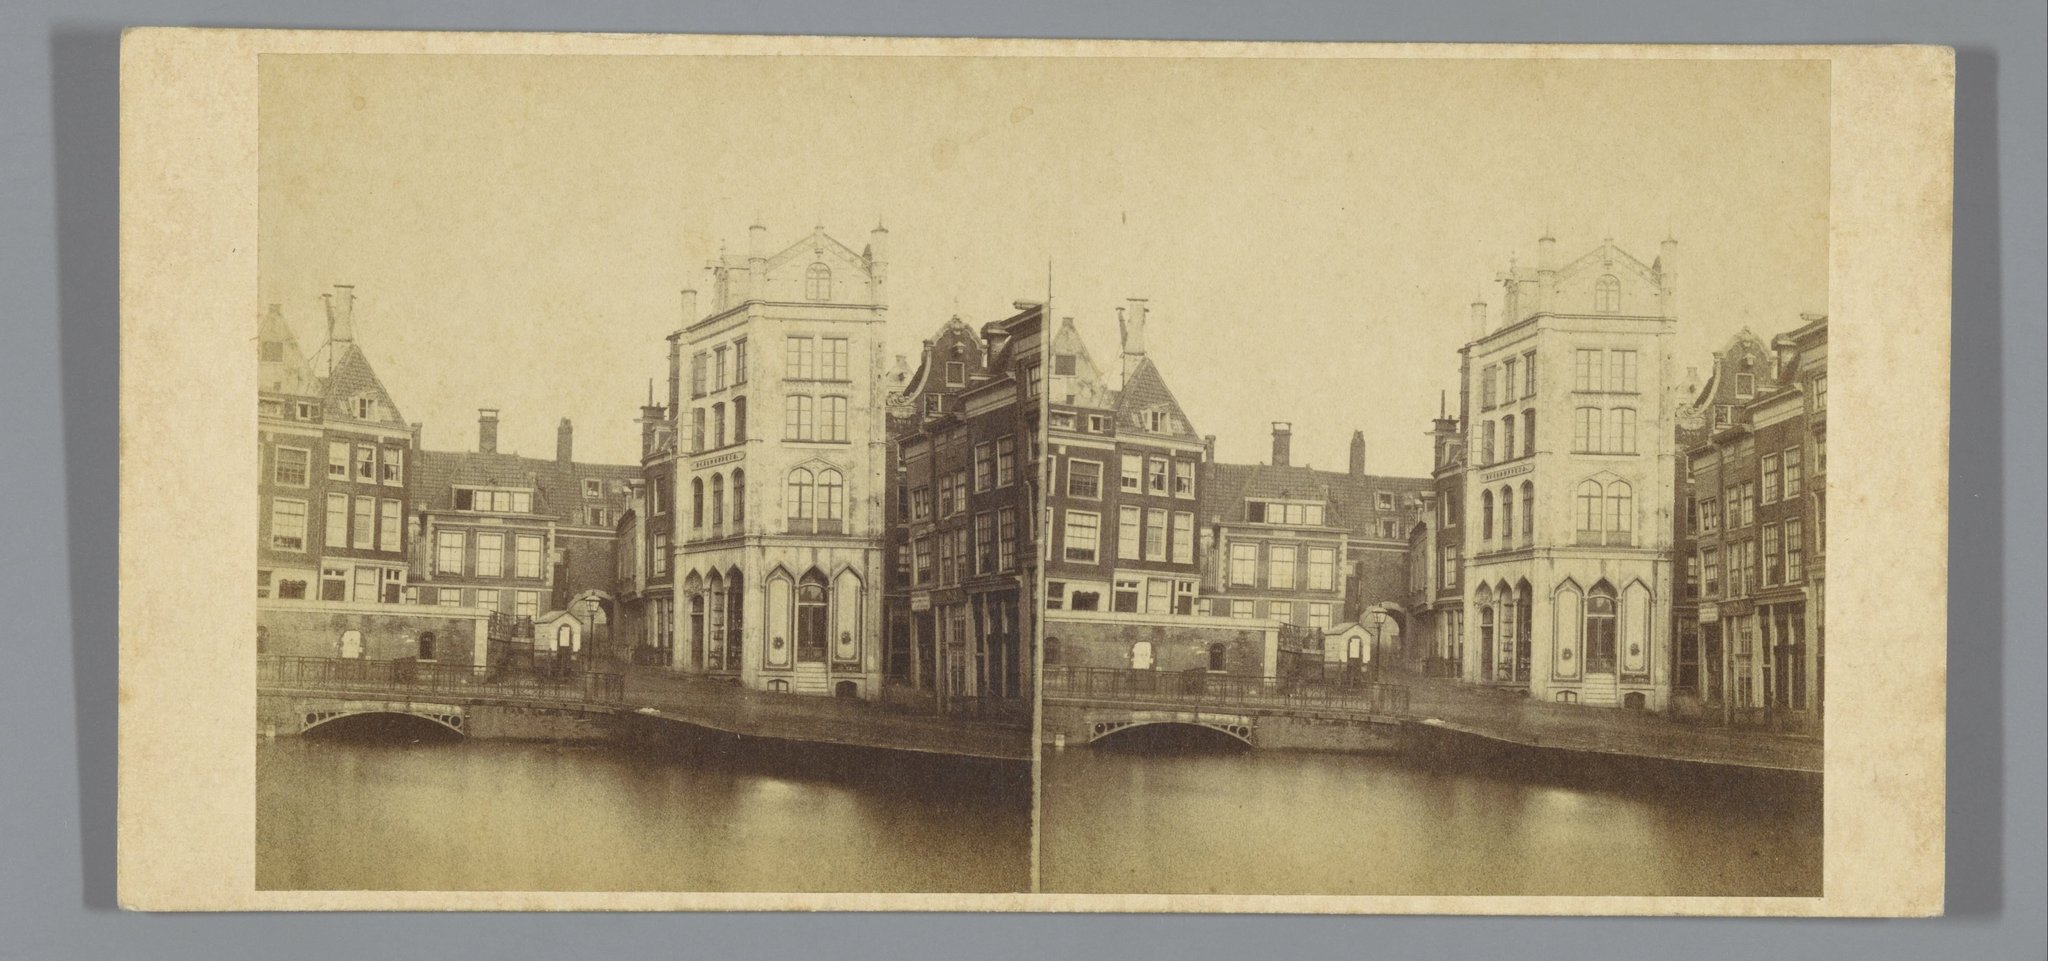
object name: stereograph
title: Beurspoortje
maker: pieter oosterhuis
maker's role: draughtsman, print maker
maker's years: 1816-1885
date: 1859-1870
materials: cardboard, paper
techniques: albumen print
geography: amsterdam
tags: canals, waters (in city)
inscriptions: number: ‘No. 218’